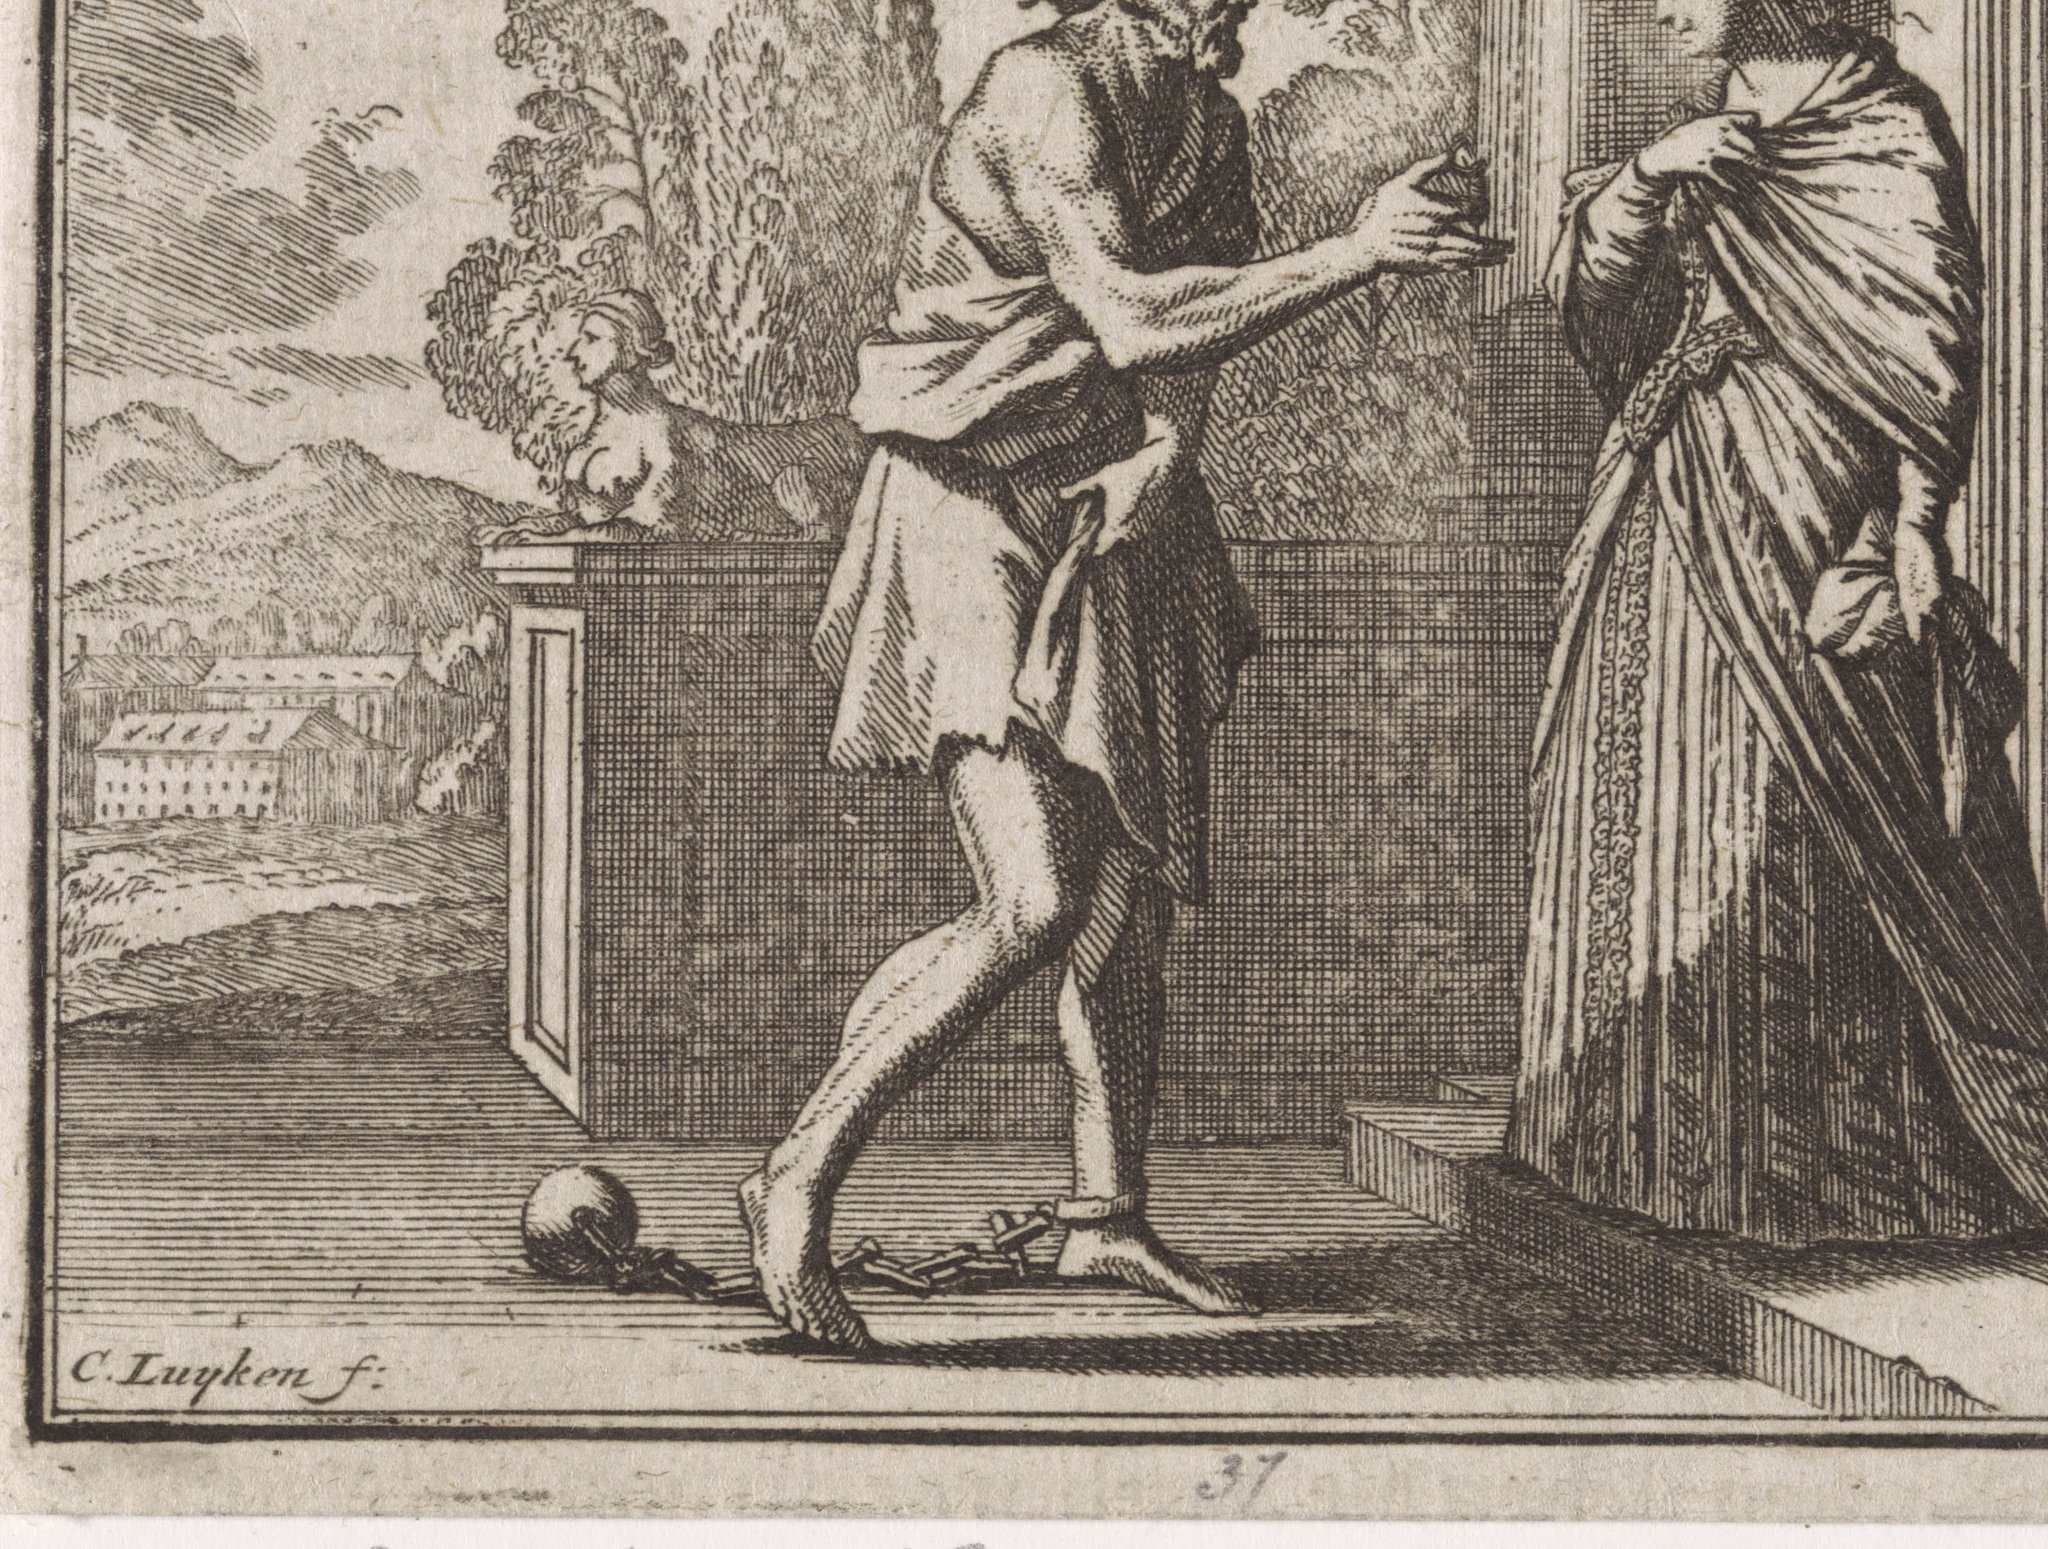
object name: book illustration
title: Das geistliche Kräuer-Buch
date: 1704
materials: paper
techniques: etching, letterpress printing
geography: nuremberg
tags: release from prison, slavery; serfs and enslaved persons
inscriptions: collector's mark: Lugt 2228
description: Illustratie uit: Abraham a Sancta Clara. Heilsames Gemisch Gemasch, das ist: Allerley seltsame und verwunderliche Geschichten (...). Neurenberg: Christoph Weigel, 1704, p. 353.